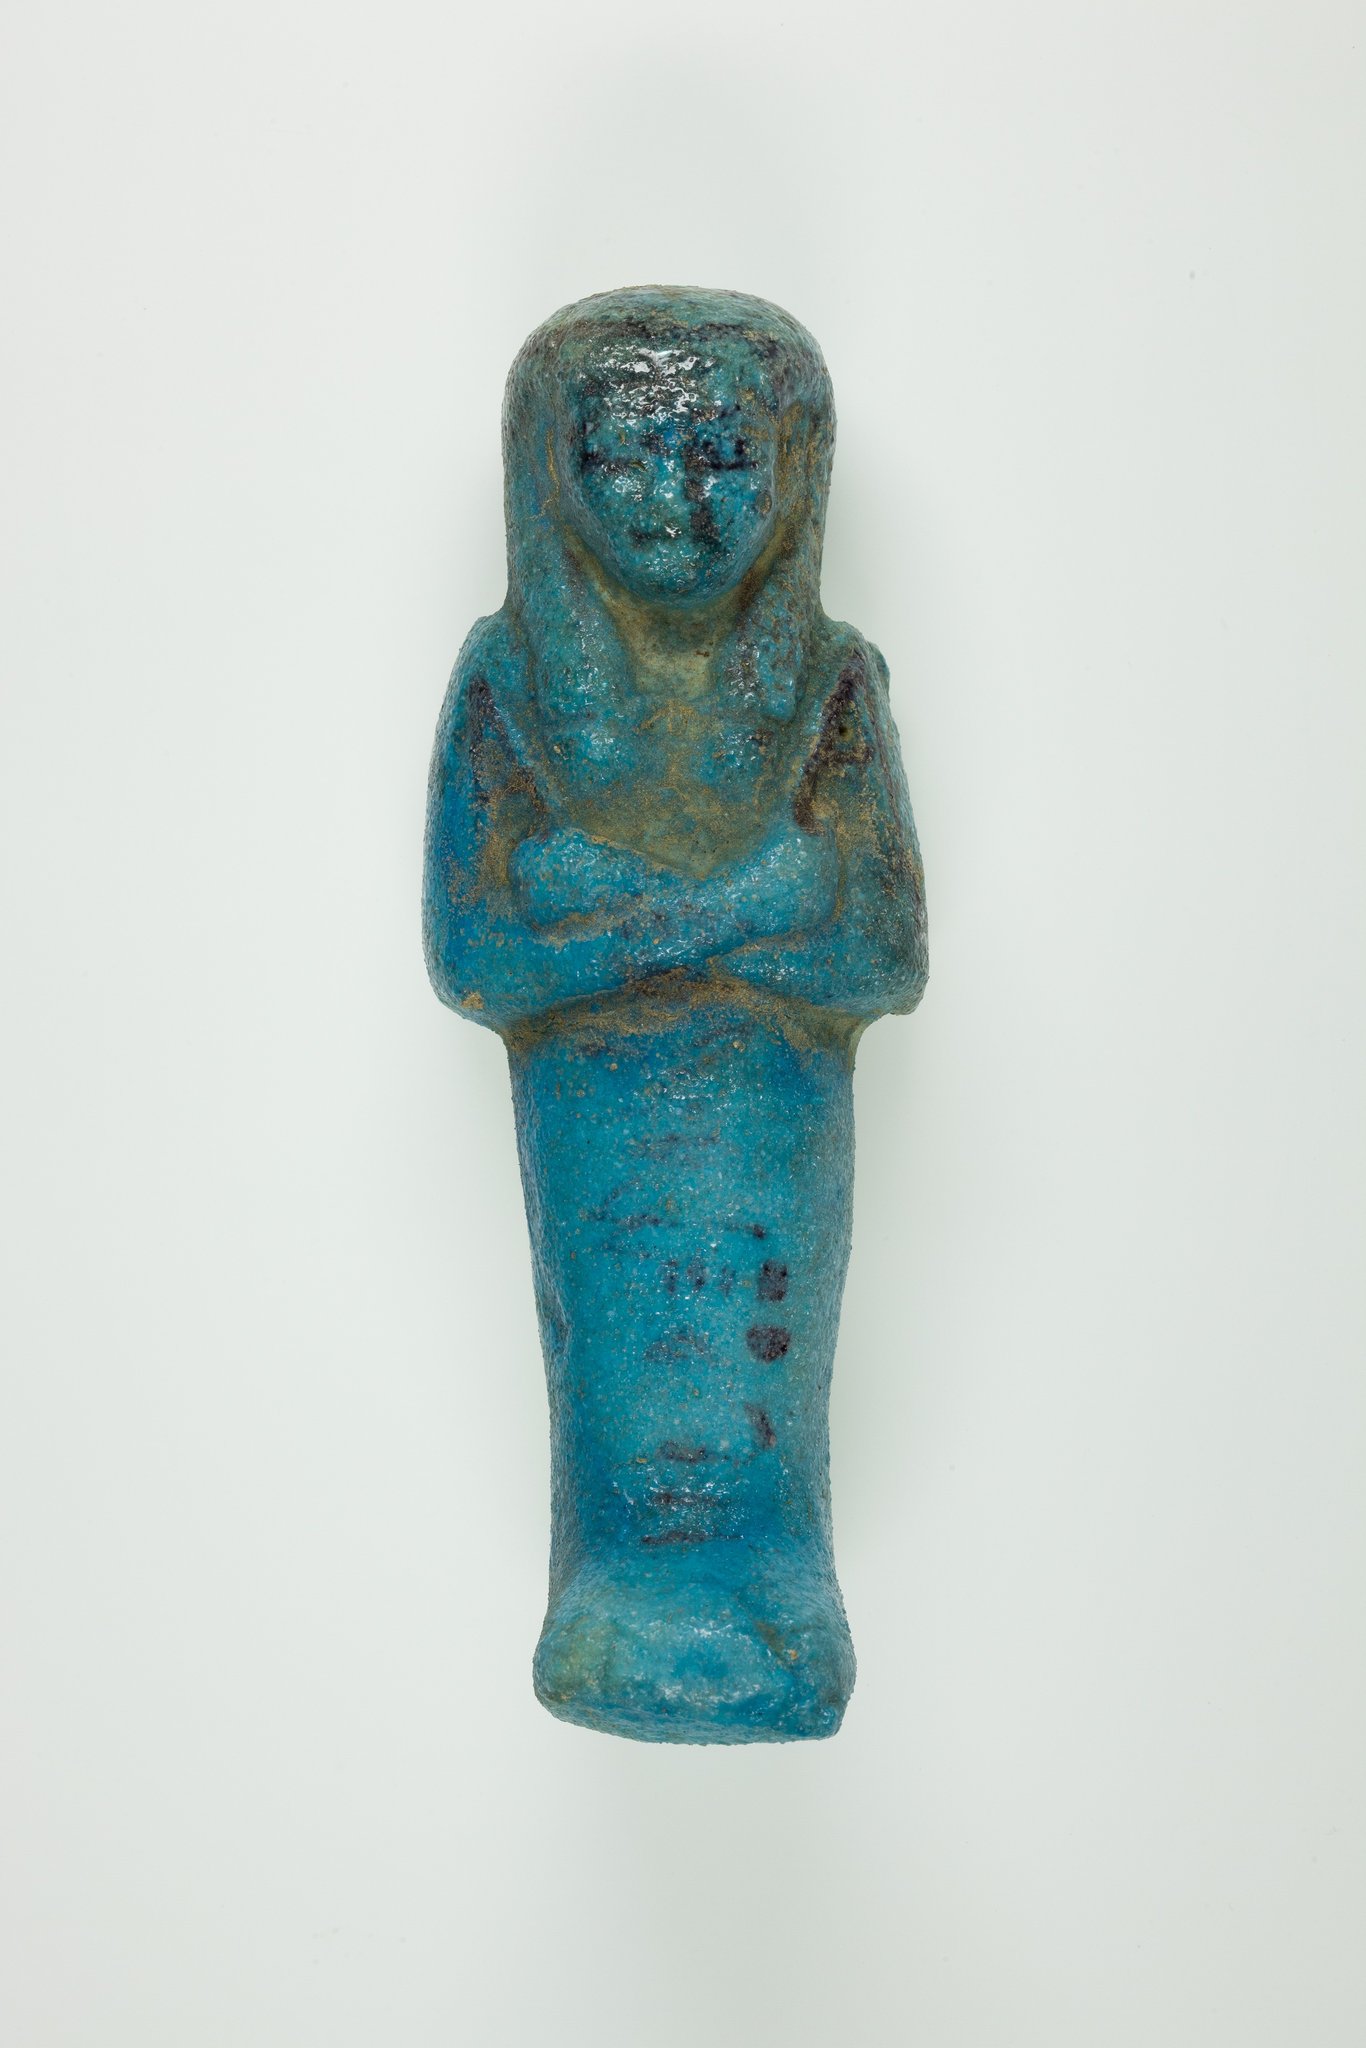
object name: worker shabti, henettawy c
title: Worker Shabti of Henettawy (C), Daughter of Isetemkheb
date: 990-970 BCE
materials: faience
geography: egypt